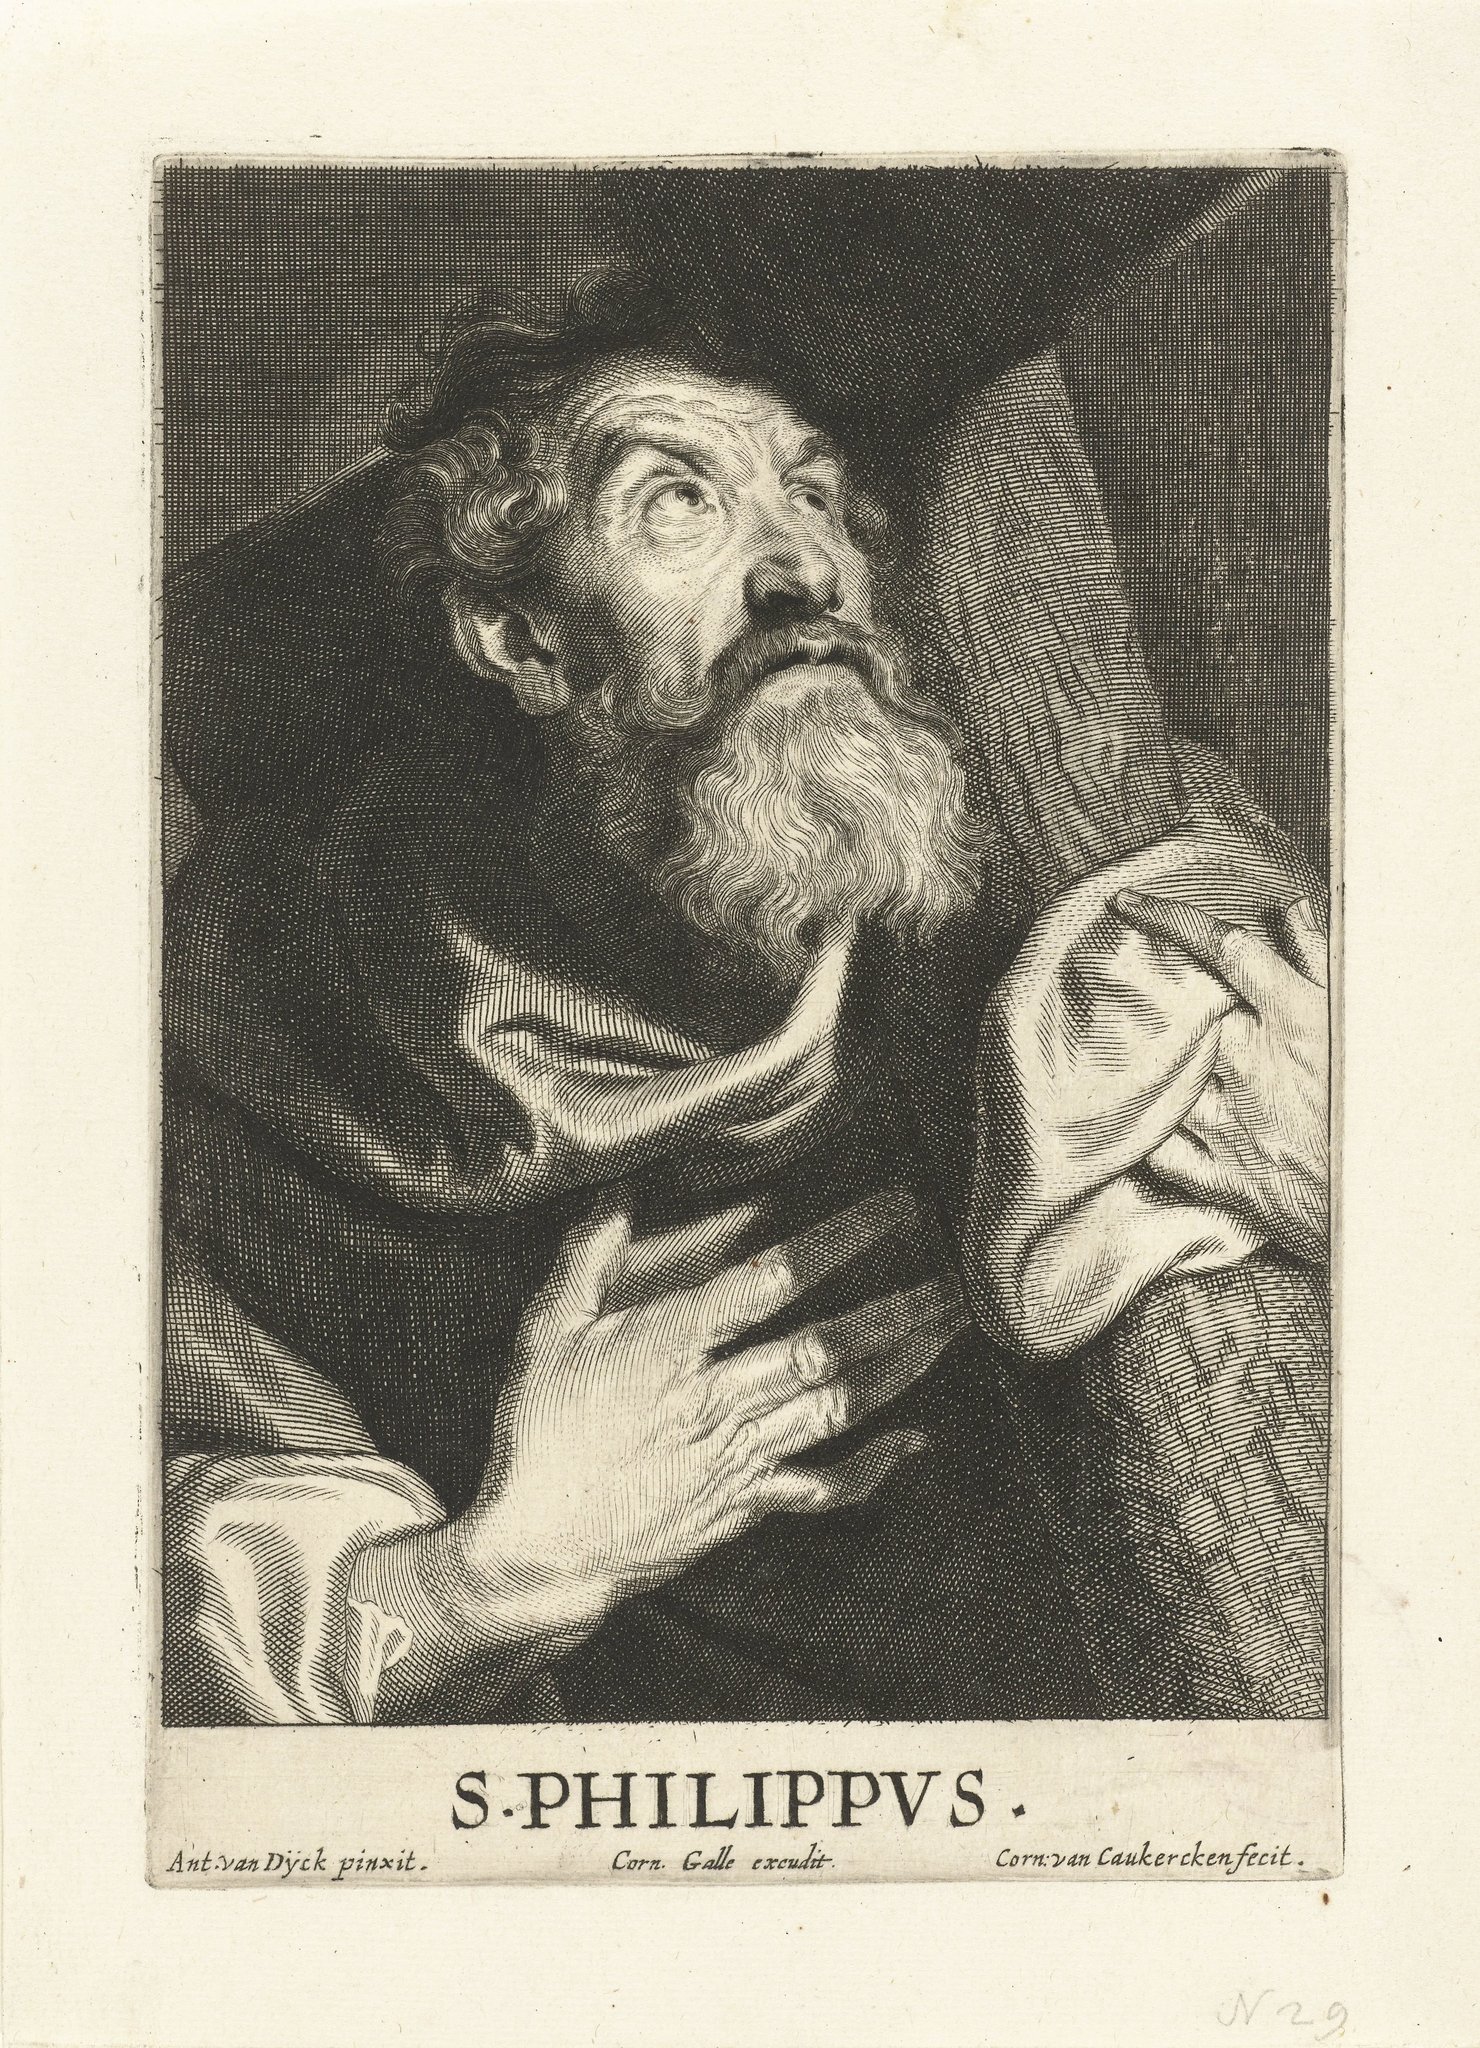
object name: print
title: Filippus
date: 1640-1680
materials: paper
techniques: engraving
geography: antwerp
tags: the apostle philip; possible attributes: book, cross, dish with snake, lance, scroll, stone, sword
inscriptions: collector's mark: Lugt 240